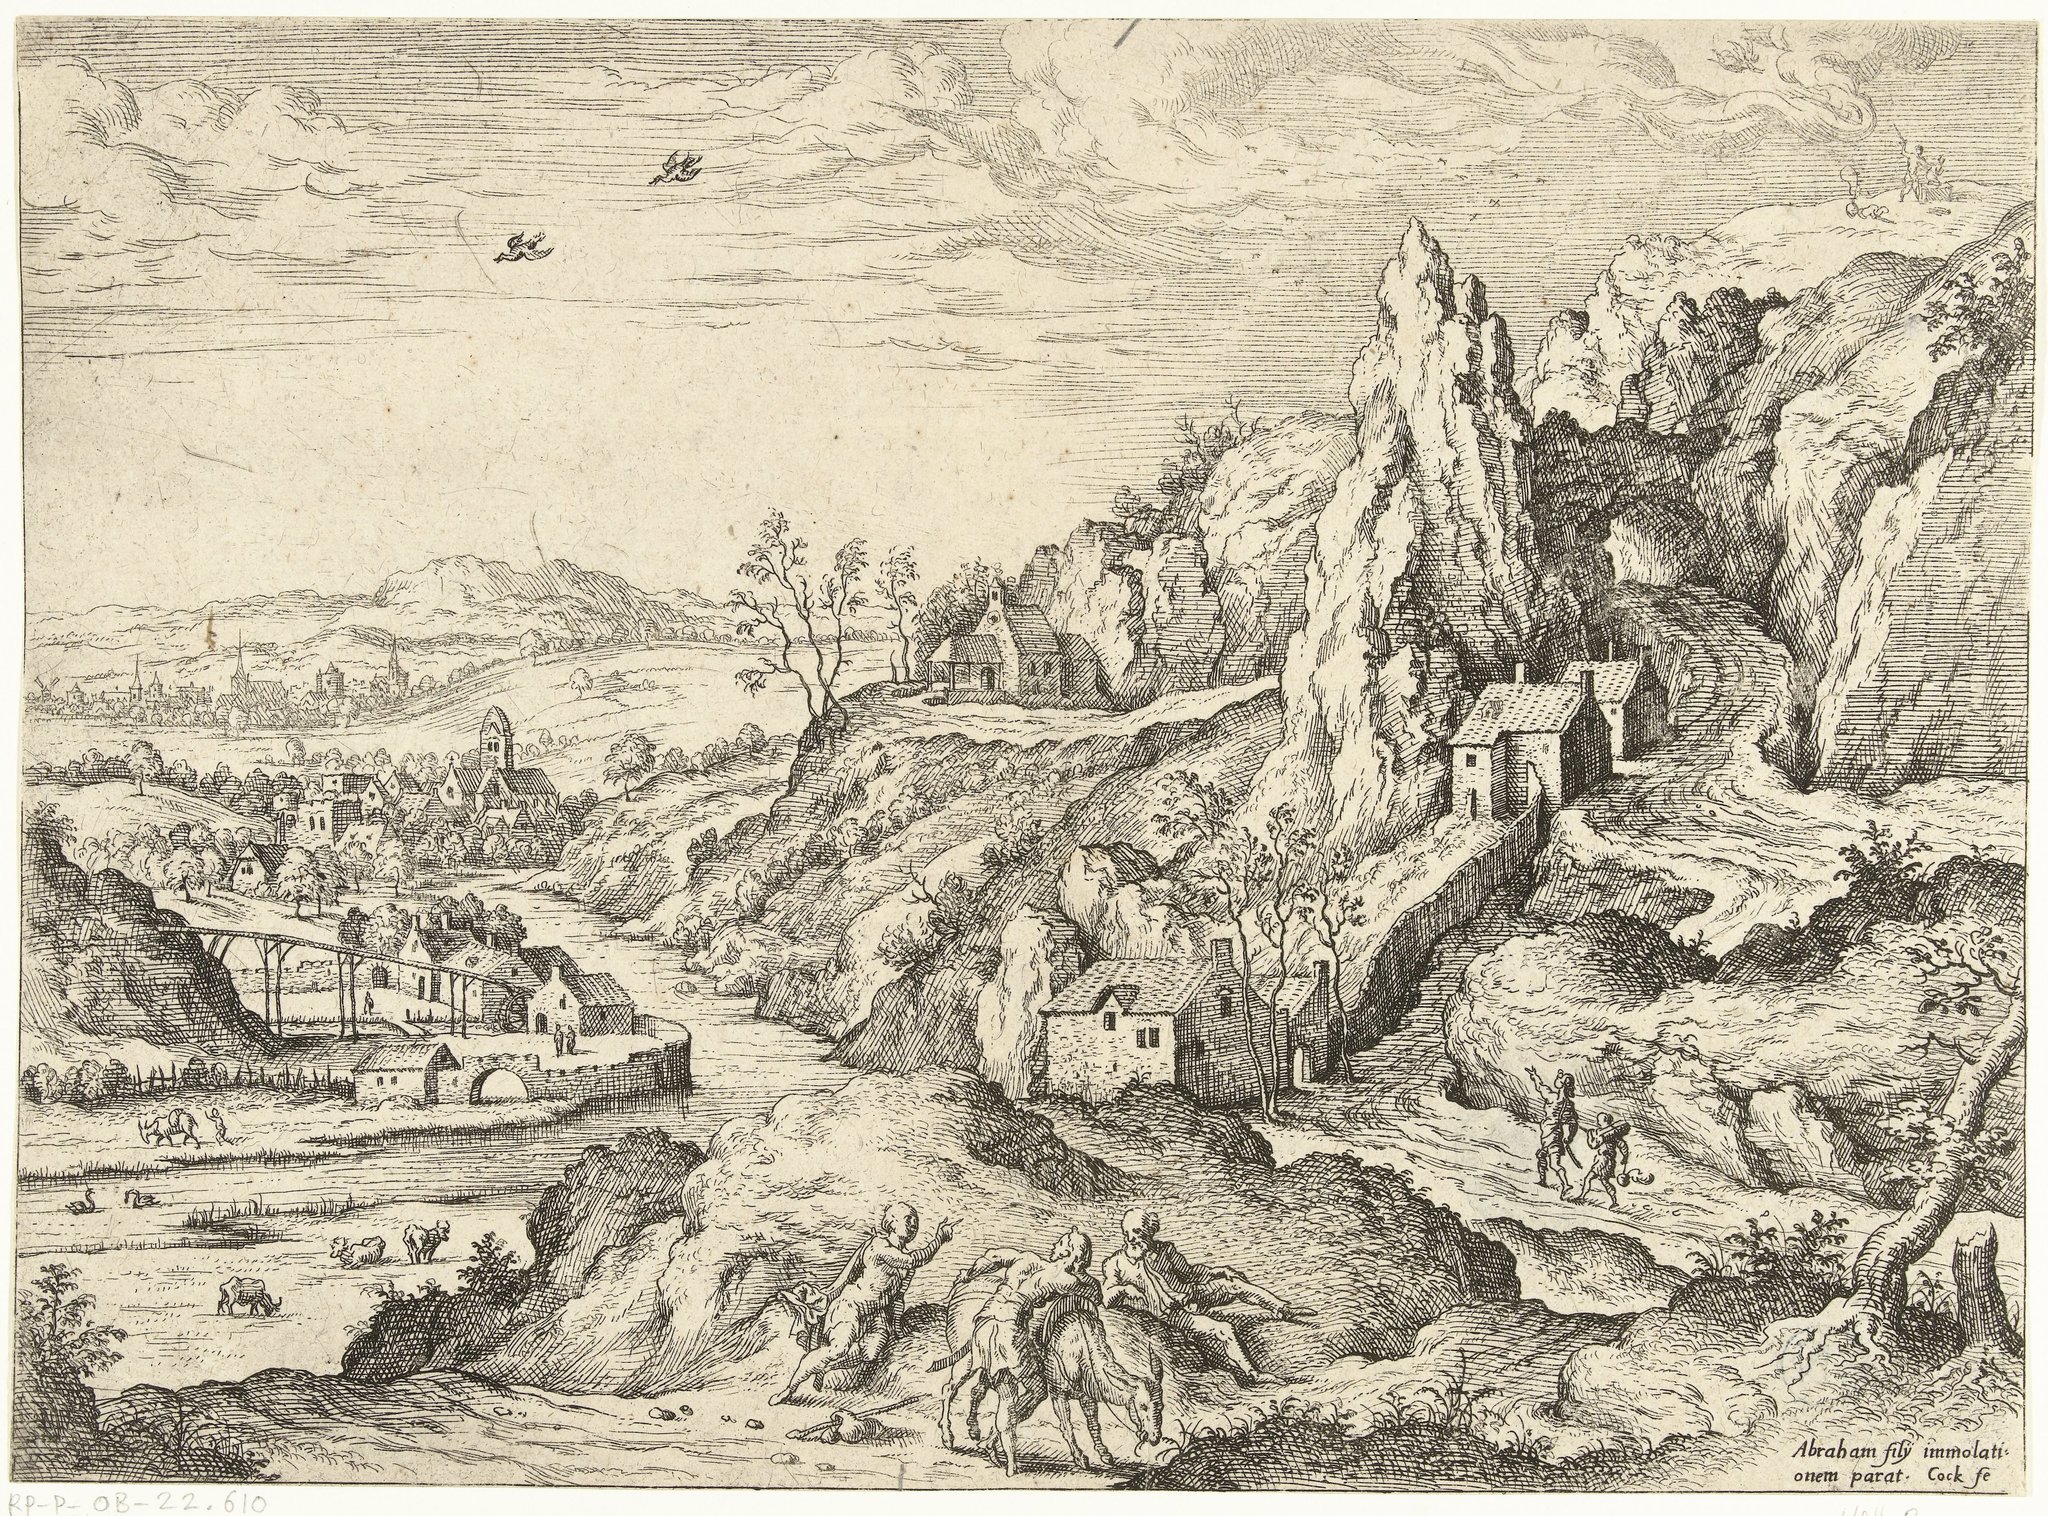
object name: print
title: Landschappen met bijbelse en mythologische scènes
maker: hieronymus cock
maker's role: print maker, publisher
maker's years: 1518-1570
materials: paper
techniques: etching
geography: antwerp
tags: abraham with isaac, an ass and the servants on their way to moriah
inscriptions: collector's mark: Lugt 1606, collector's mark: Lugt 2529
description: Landschap in de bergen, door het dal loopt een rivier. Op een pad wandelen Abraham en Isaak naar de offerplaats boven op een berg. Isaak draagt het hout voor het vuur op zijn rug. Rechts boven in de verte de top van de berg waar het offer plaats vindt. Vanuit de hemel daalt de engel neer om Abraham te weerhouden zijn zoon Isaak te offeren. Prent uit een serie van 13 landschappen met bijbelse en mythologische scènes.